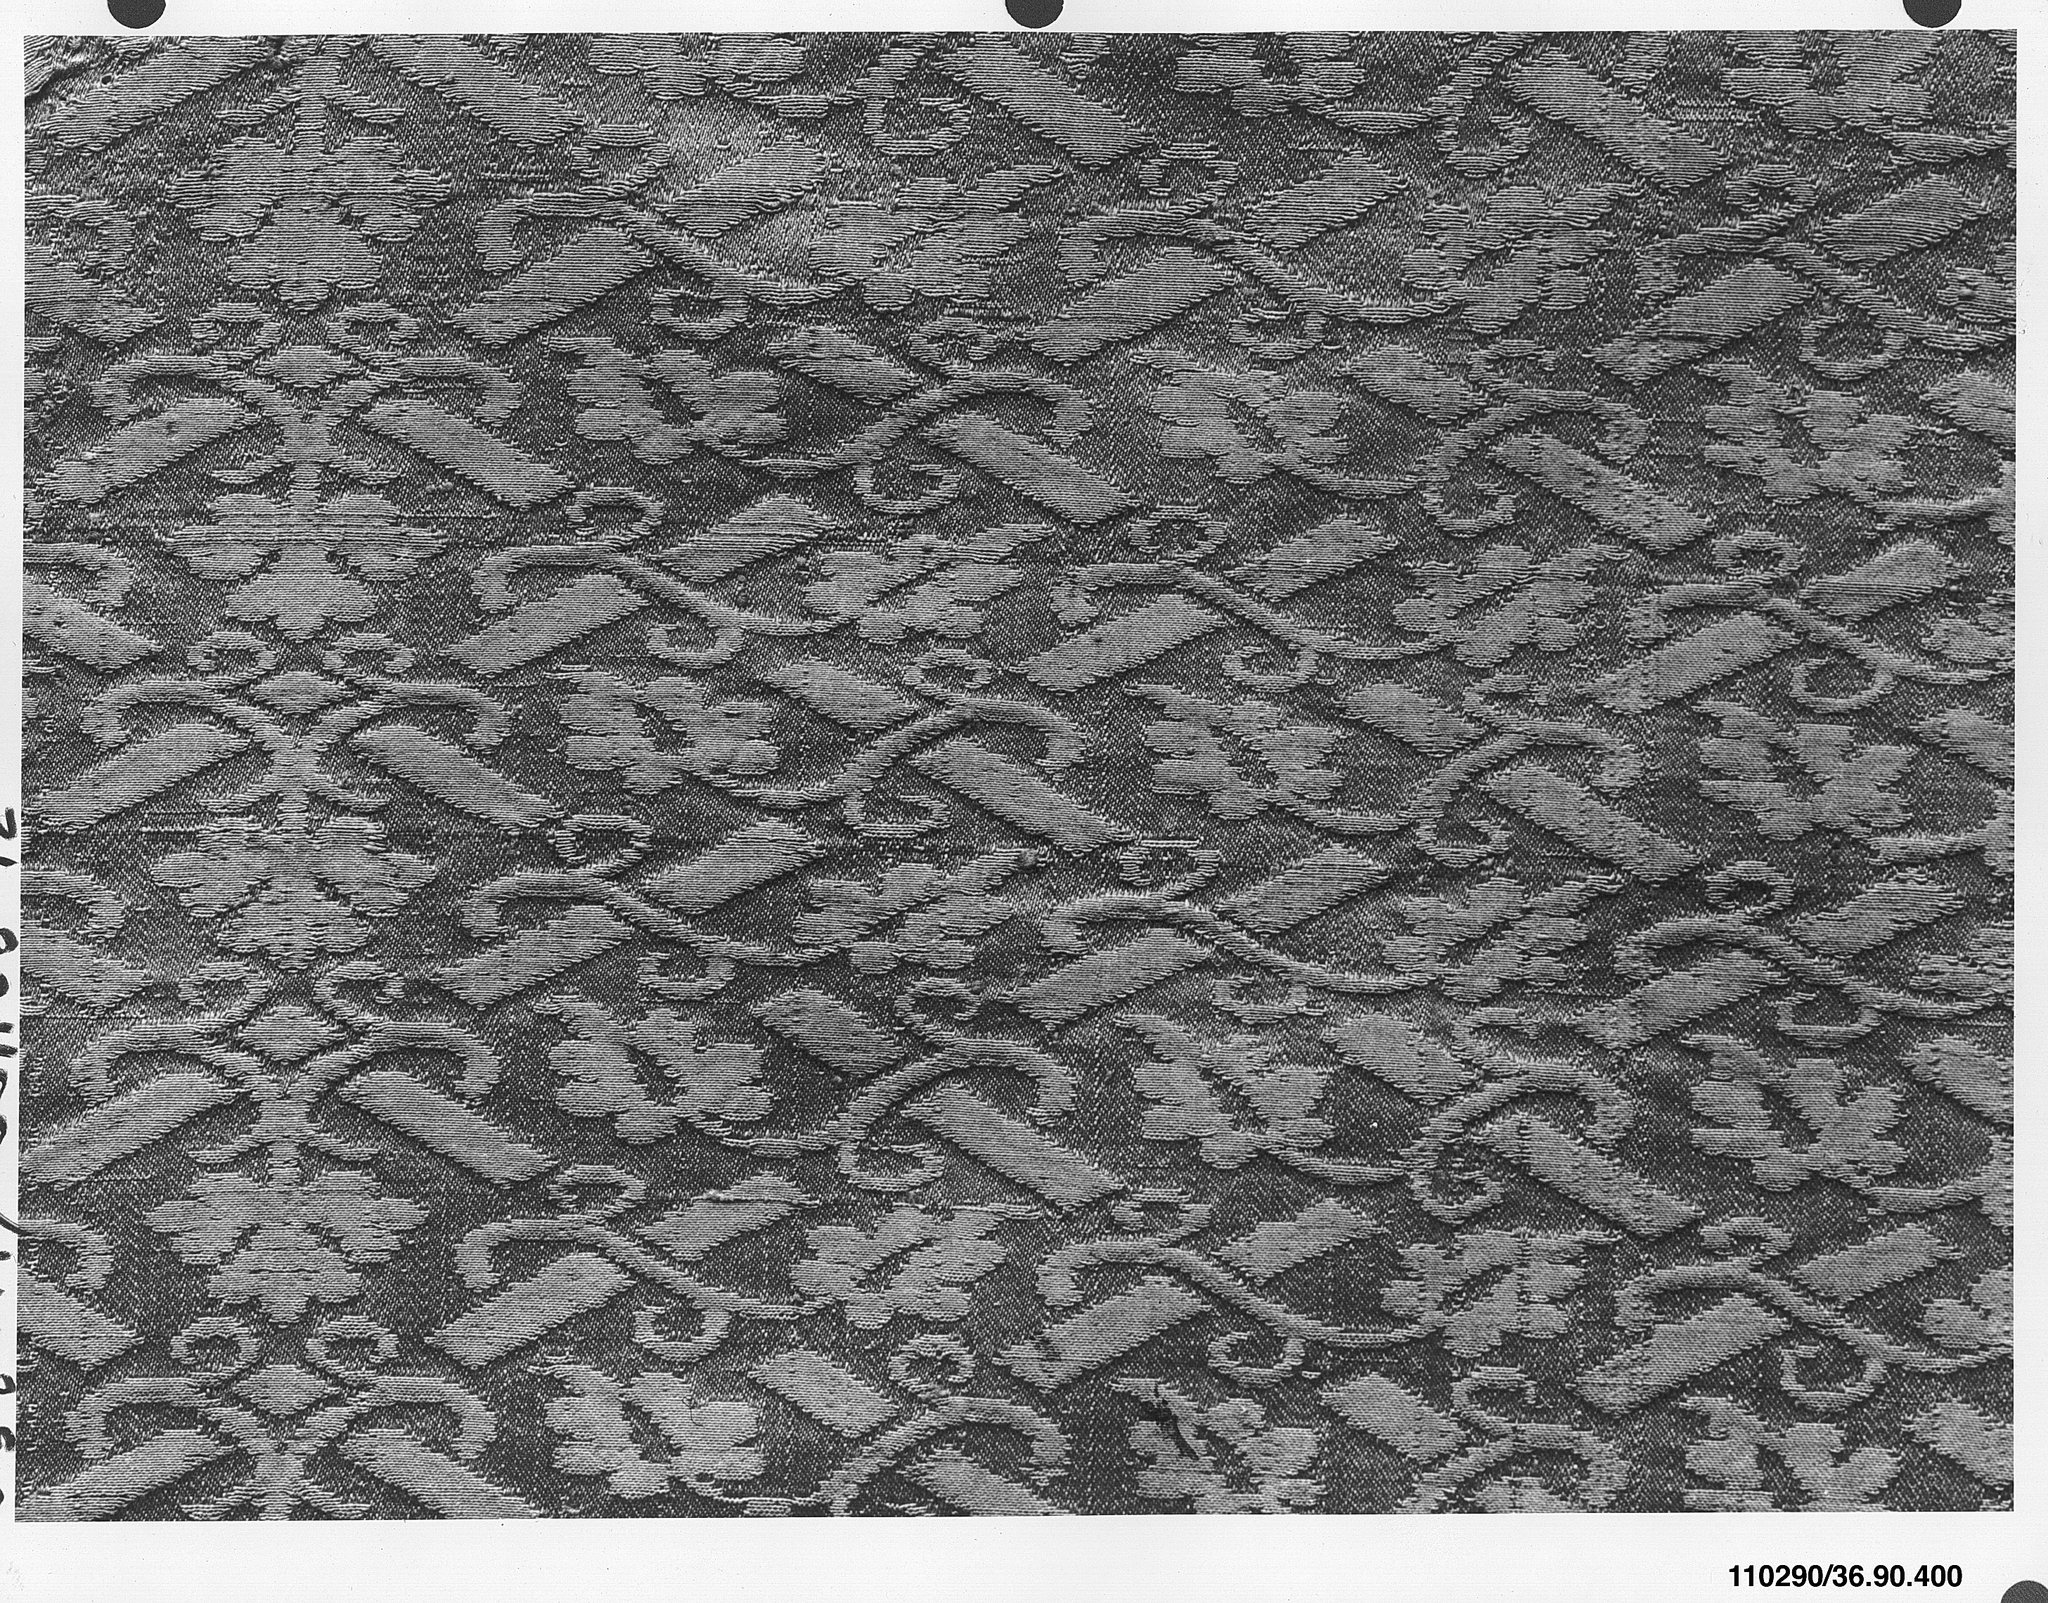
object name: piece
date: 1501-1700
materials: silk